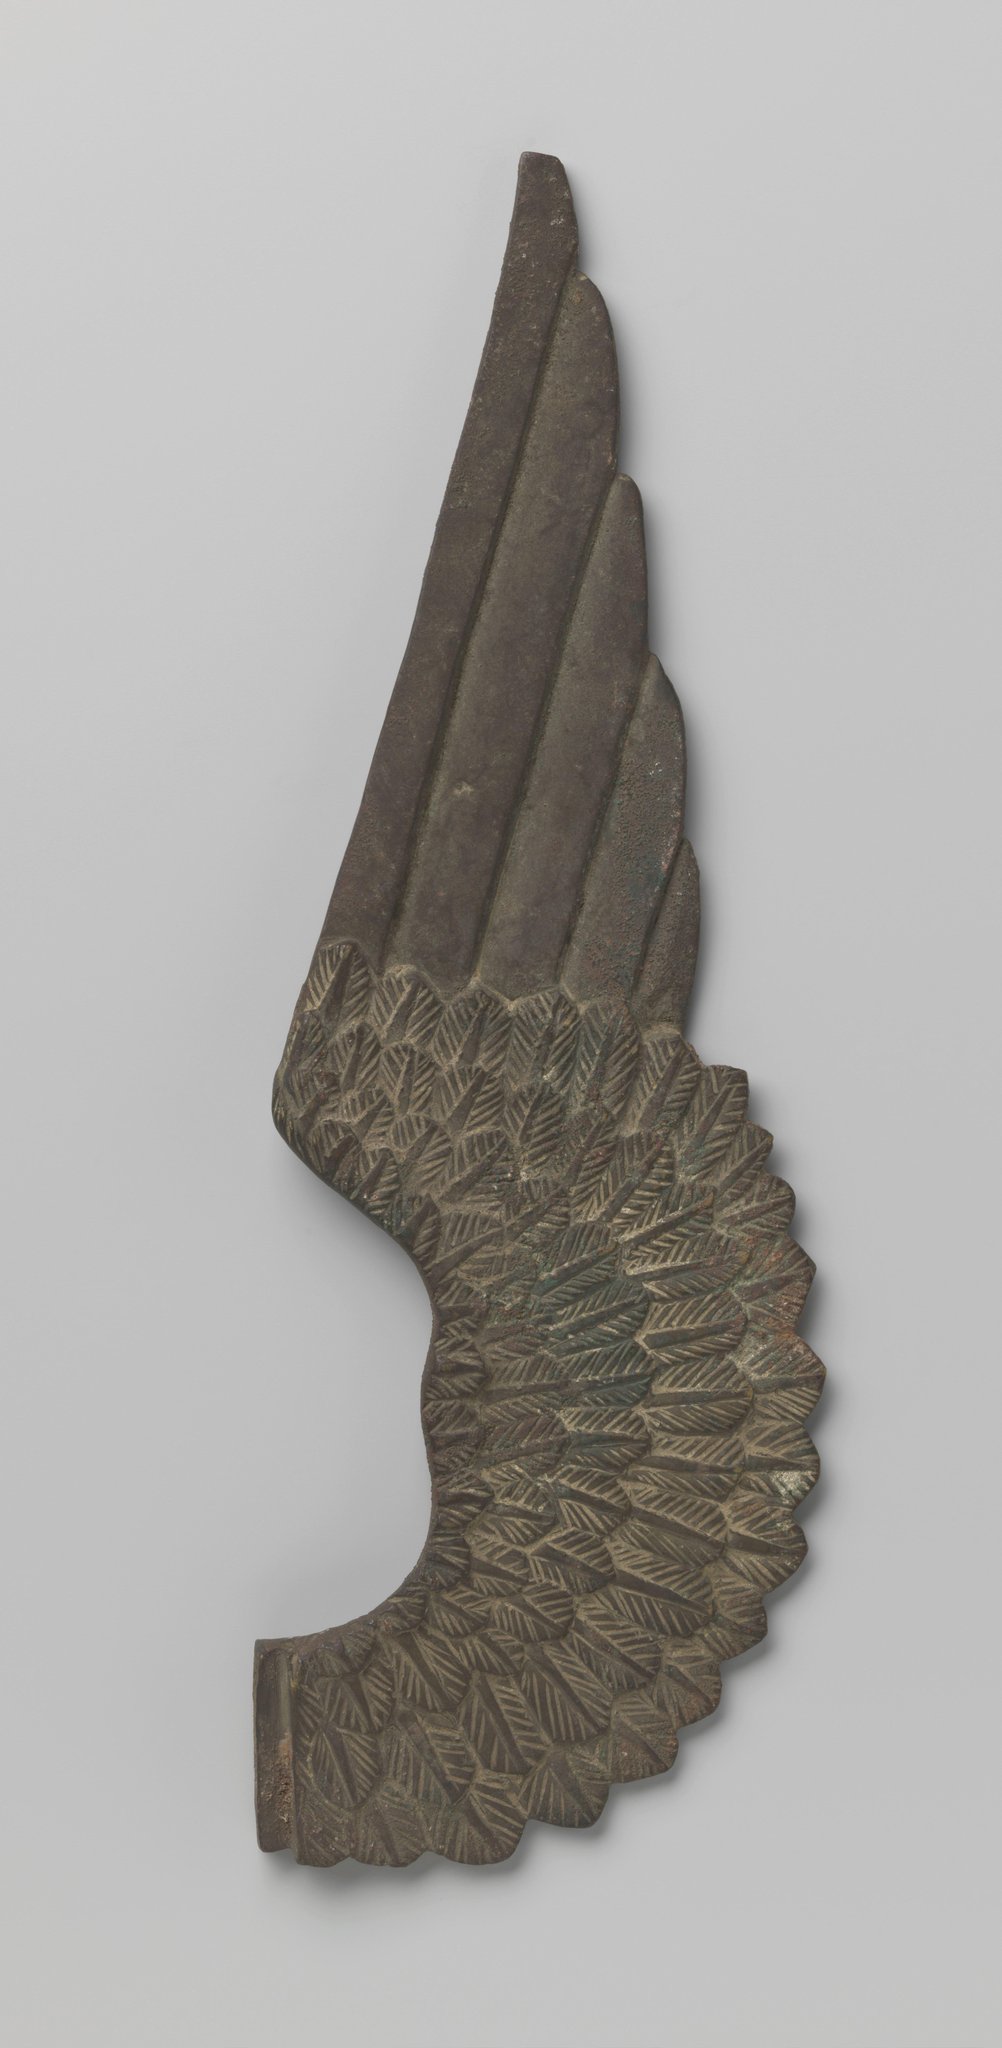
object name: engelenvleugel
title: Engelenvleugel van messing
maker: Anonymous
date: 1400-1500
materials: brass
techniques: casting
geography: northern netherlands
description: Bodemvondst: De vleugels zijn waarschijnlijk opgegraven bij de Grote of St.-Jacobskerk te Den Haag in 1857, samen met de kaarsenkroon (BK-NM-9387-A). In de brief van 5 mei 1891 van de directeur van het Nederlandsch Museum welke betrekking heeft op de aankoop van deze collectie, behoren deze vleugels vermoedelijk tot de 'losse armen en andere fragmenten.' Wellicht zijn deze vleugels onderdelen geweest van engelenfiguren (met lijdenswerktuigen?) die op een lichtboog (of herse) hebben gestaan.